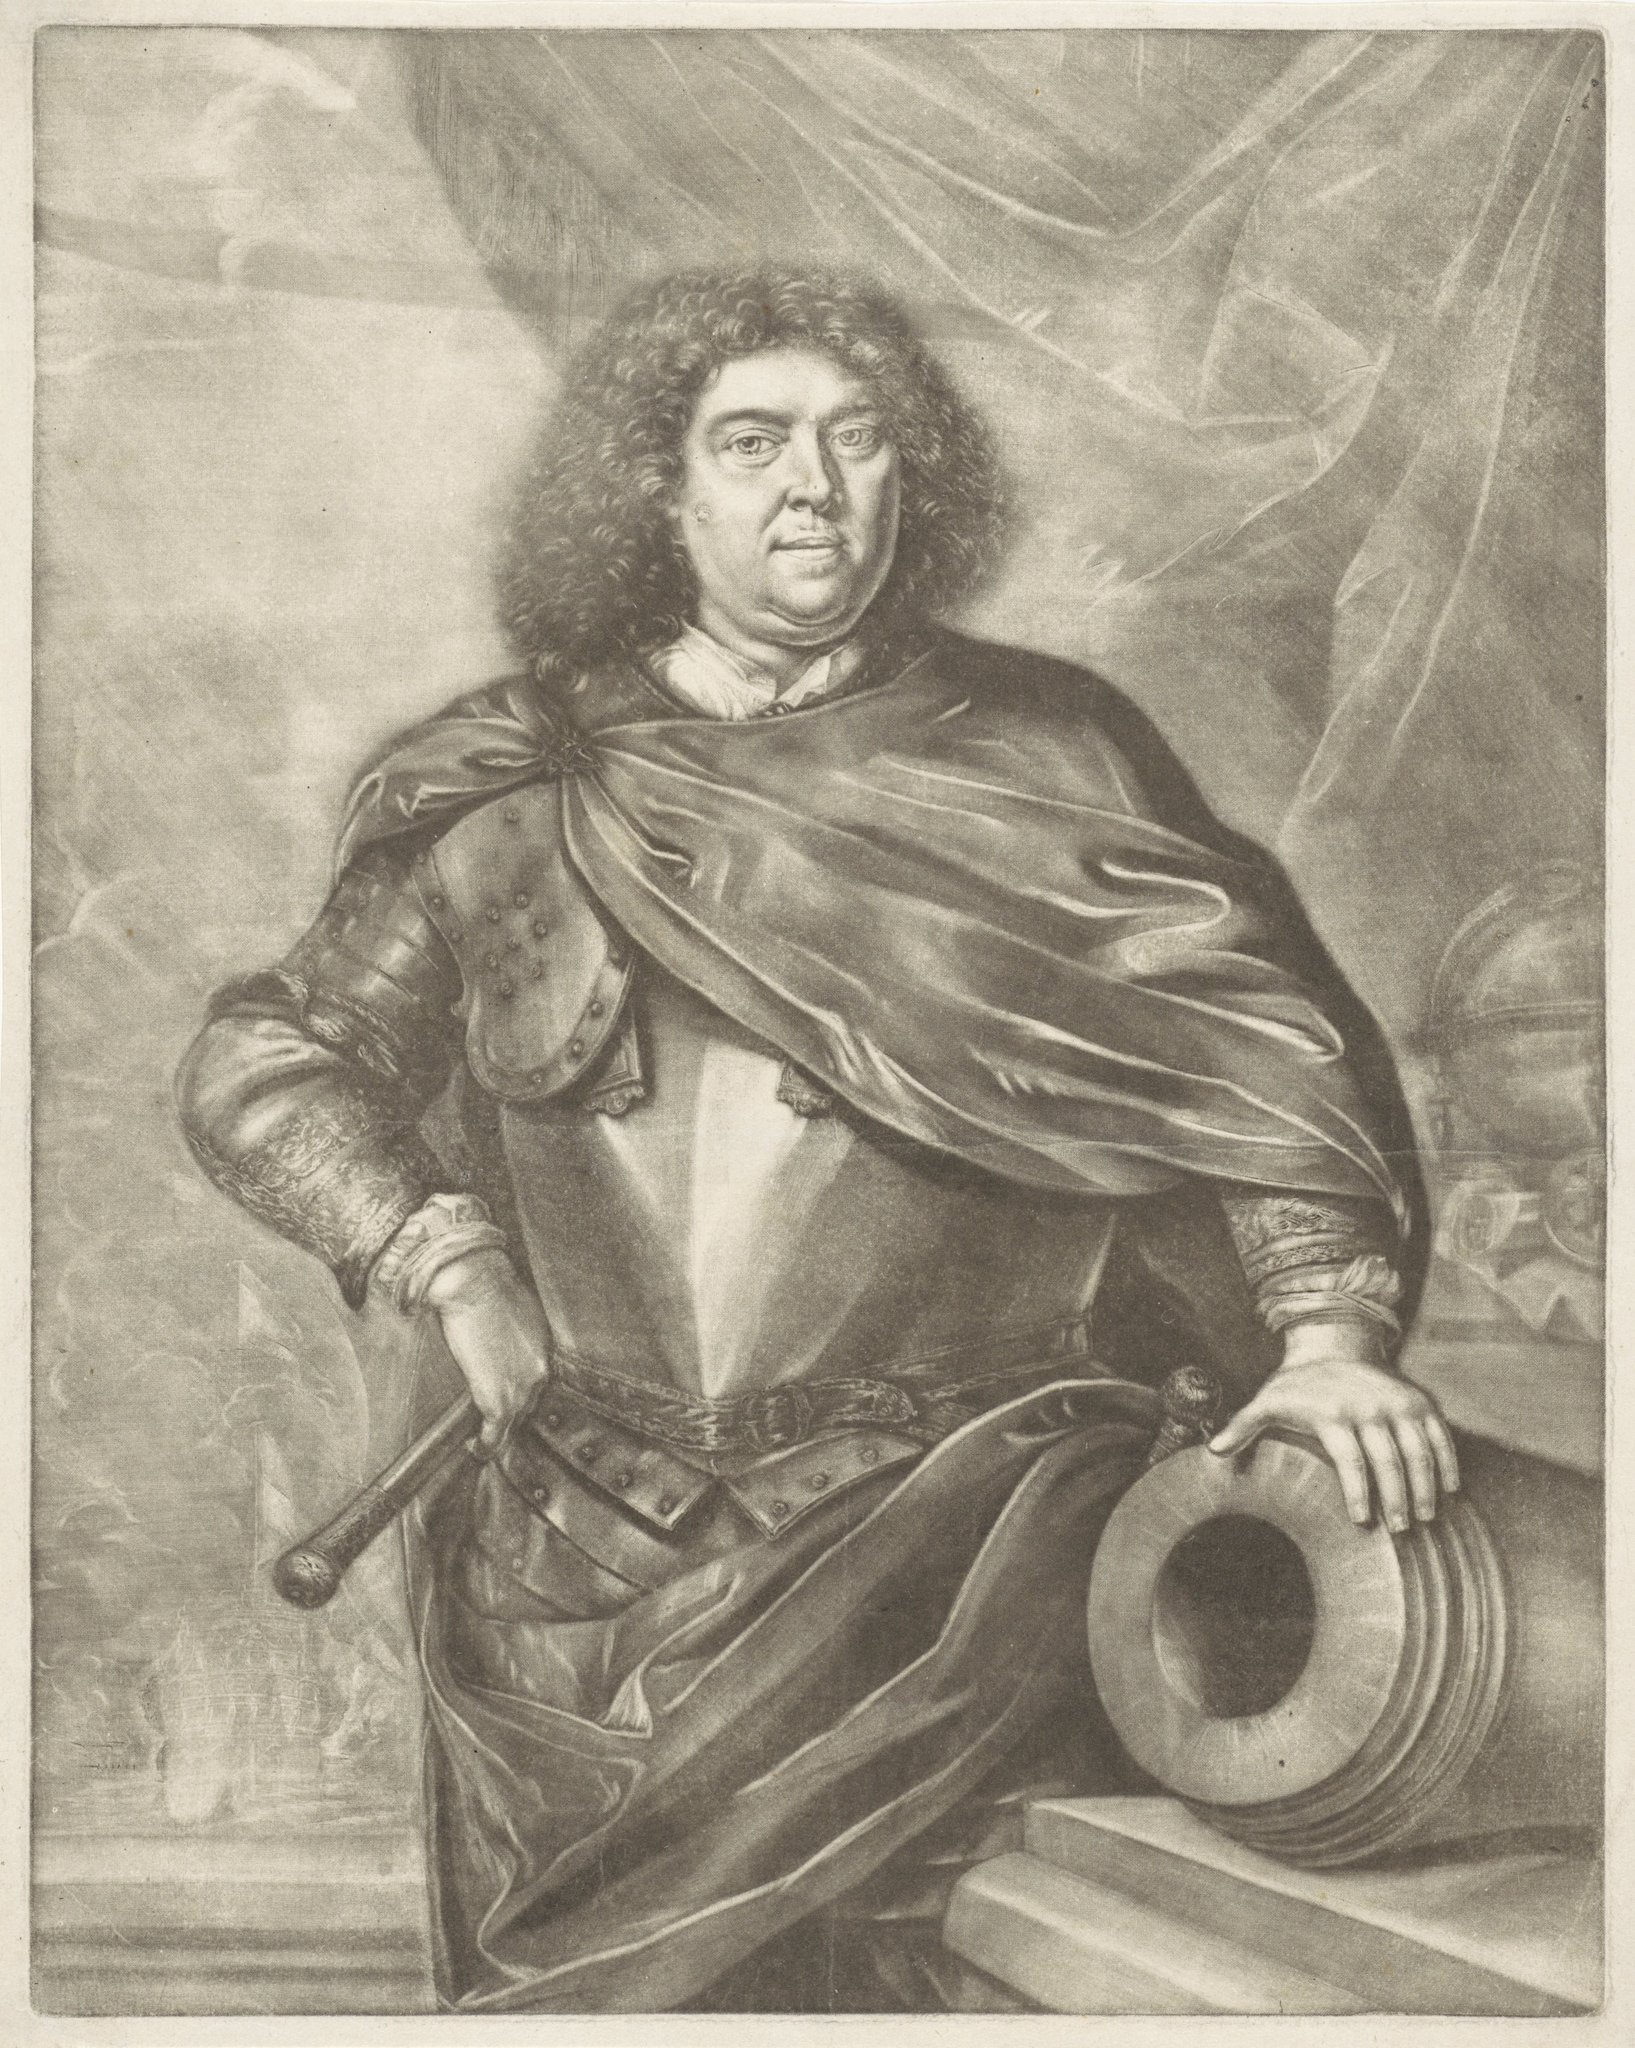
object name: print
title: Portret van Pieter Gilles Schey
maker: thomas van der wilt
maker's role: draughtsman, print maker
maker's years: 1659-1733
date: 1673-1733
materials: paper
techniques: mezzotint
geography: delft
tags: sailing-ship, sailing-boat, battle (+ naval force), globe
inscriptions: collector's mark: Lugt 2228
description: De admiraal Pieter Gilles Schey. Hij leunt met zijn hand op een kanon en heeft in de andere hand de aanvoerderstaf. Op de achtergrond een zeeslag.